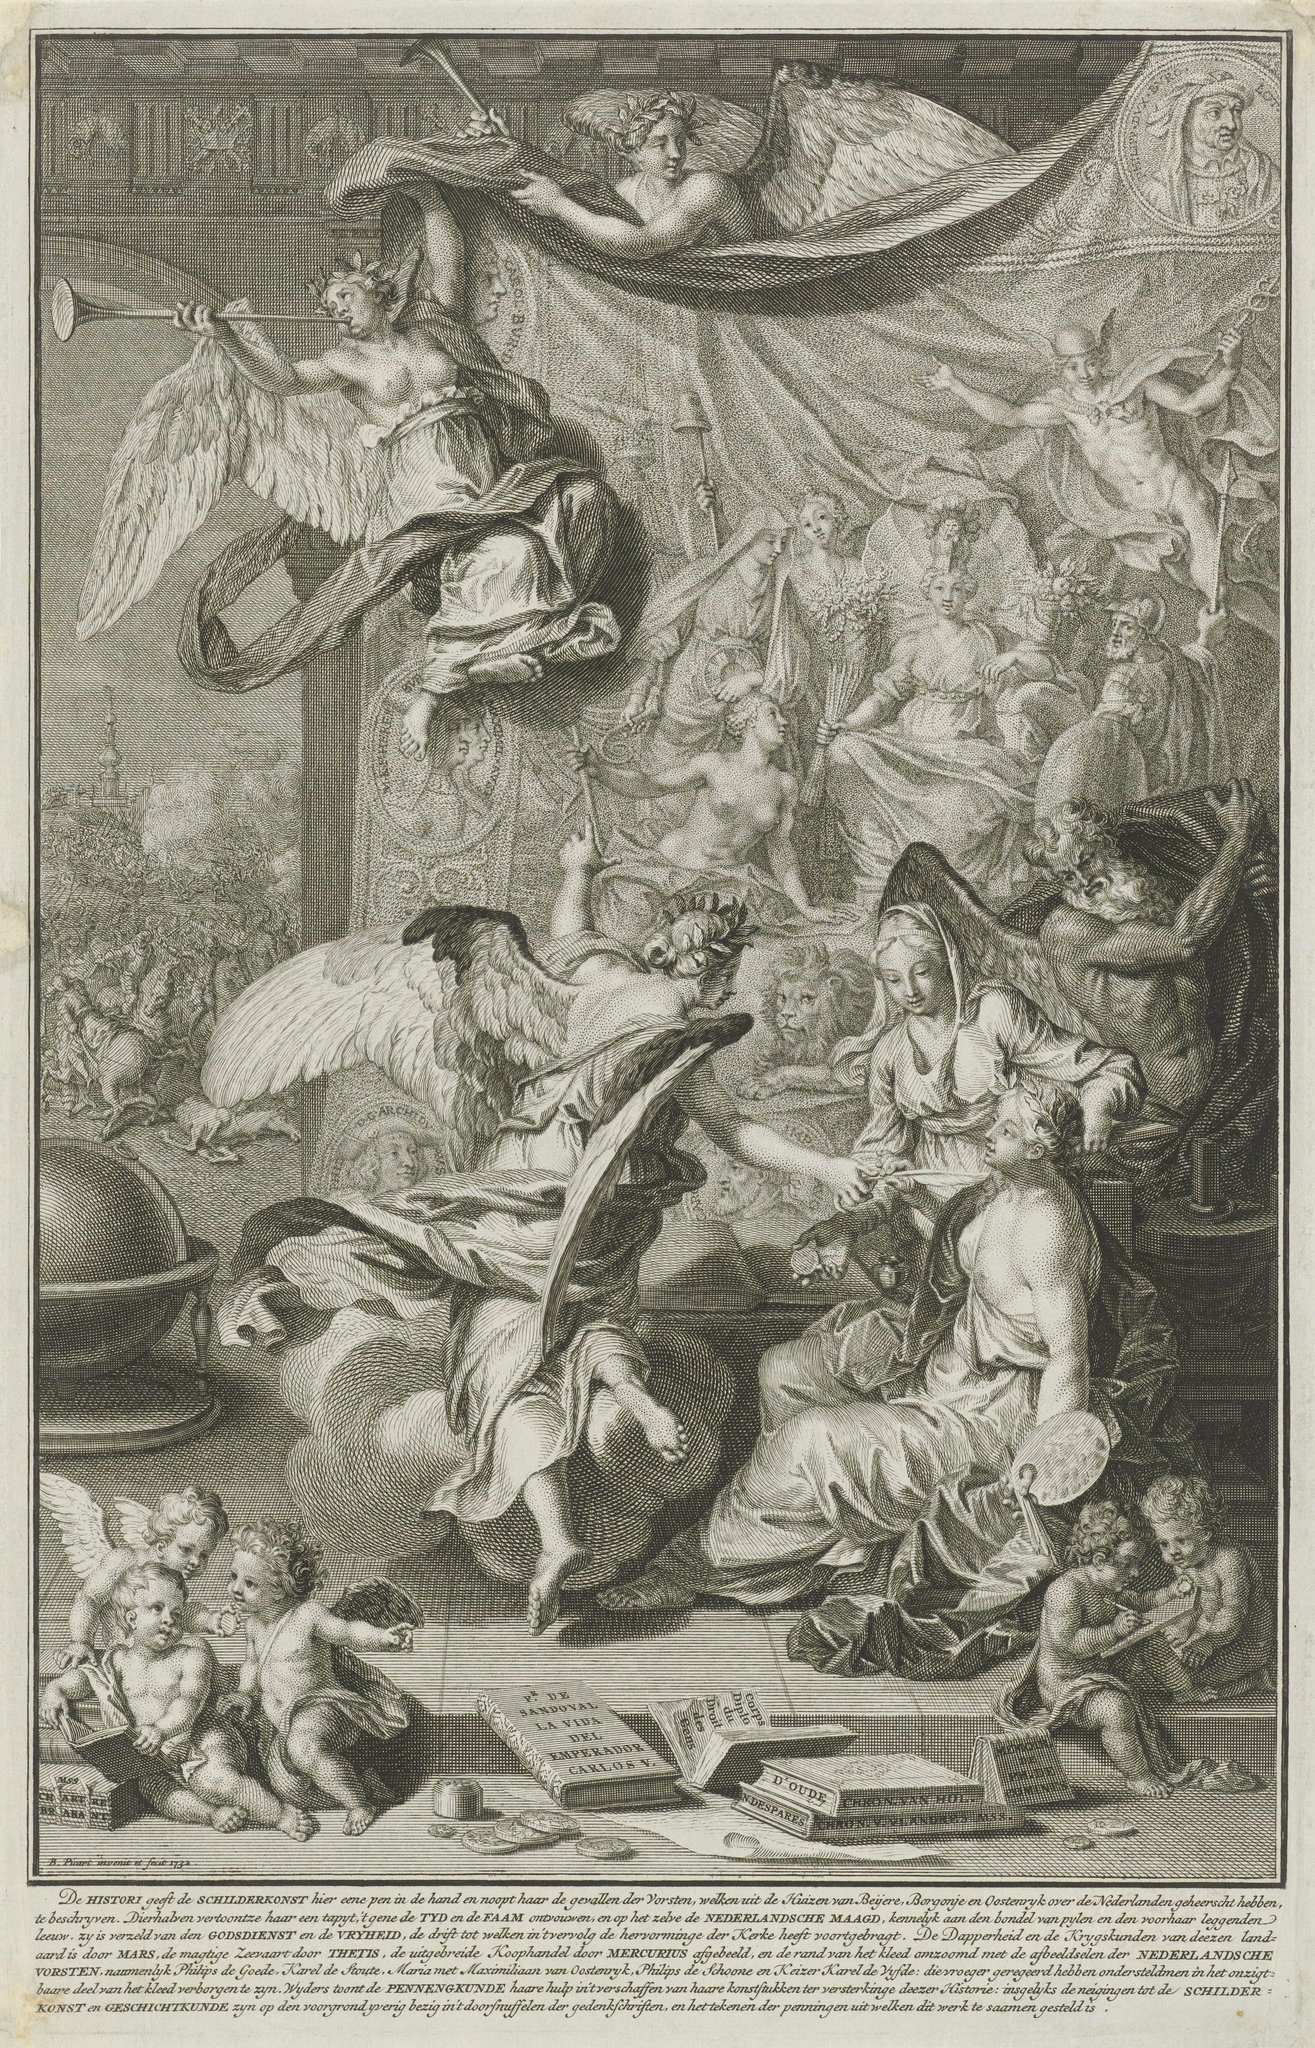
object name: titelblad, titelpagina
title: Titelpagina voor: F. van Mieris, Histori der Nederlandsche vorsten, 1732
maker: bernard picart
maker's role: draughtsman, print maker, publisher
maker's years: 1673-1733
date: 1732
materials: paper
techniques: engraving, etching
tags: ghent, charles v (holy roman emperor and king of spain), (story of) mars (ares), faith, 'fides'; 'fede', 'fede catholica', 'fede christiana', 'fede christiana catholica' (ripa) ~ one of the three theological virtues, 'pictura', symbolic representations, allegories and emblems ~ painting; 'pittura' (ripa), personifications of countries, nations, states, districts, etc., (story of) thetis; 'thethi, ninfa del mare' (ripa), 'historia'; 'historia' (ripa), fame; 'fama', 'fama buona', 'fama chiara' (ripa), freedom, liberty; 'libertà' (ripa), father time, man with wings and scythe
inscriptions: collector's mark: Lugt 240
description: Allegorische voorstelling waarin Geschiedenis de Schilderkunst een schrijfveer in de hand geeft om de geschiedenissen van de Nederlandse vorsten op te tekenen. Ze wijst op een tapijt waarop de Nederlandse Maagd, vergezeld door Vrijheid, Geloof, Thetis, Mars en Mercurius en langs de randen medaillons waarin de portretten van Nederlandse vorsten. Links op de achtergrond een veldslag. Met een zevenregelig onderschrift in het Nederlands.